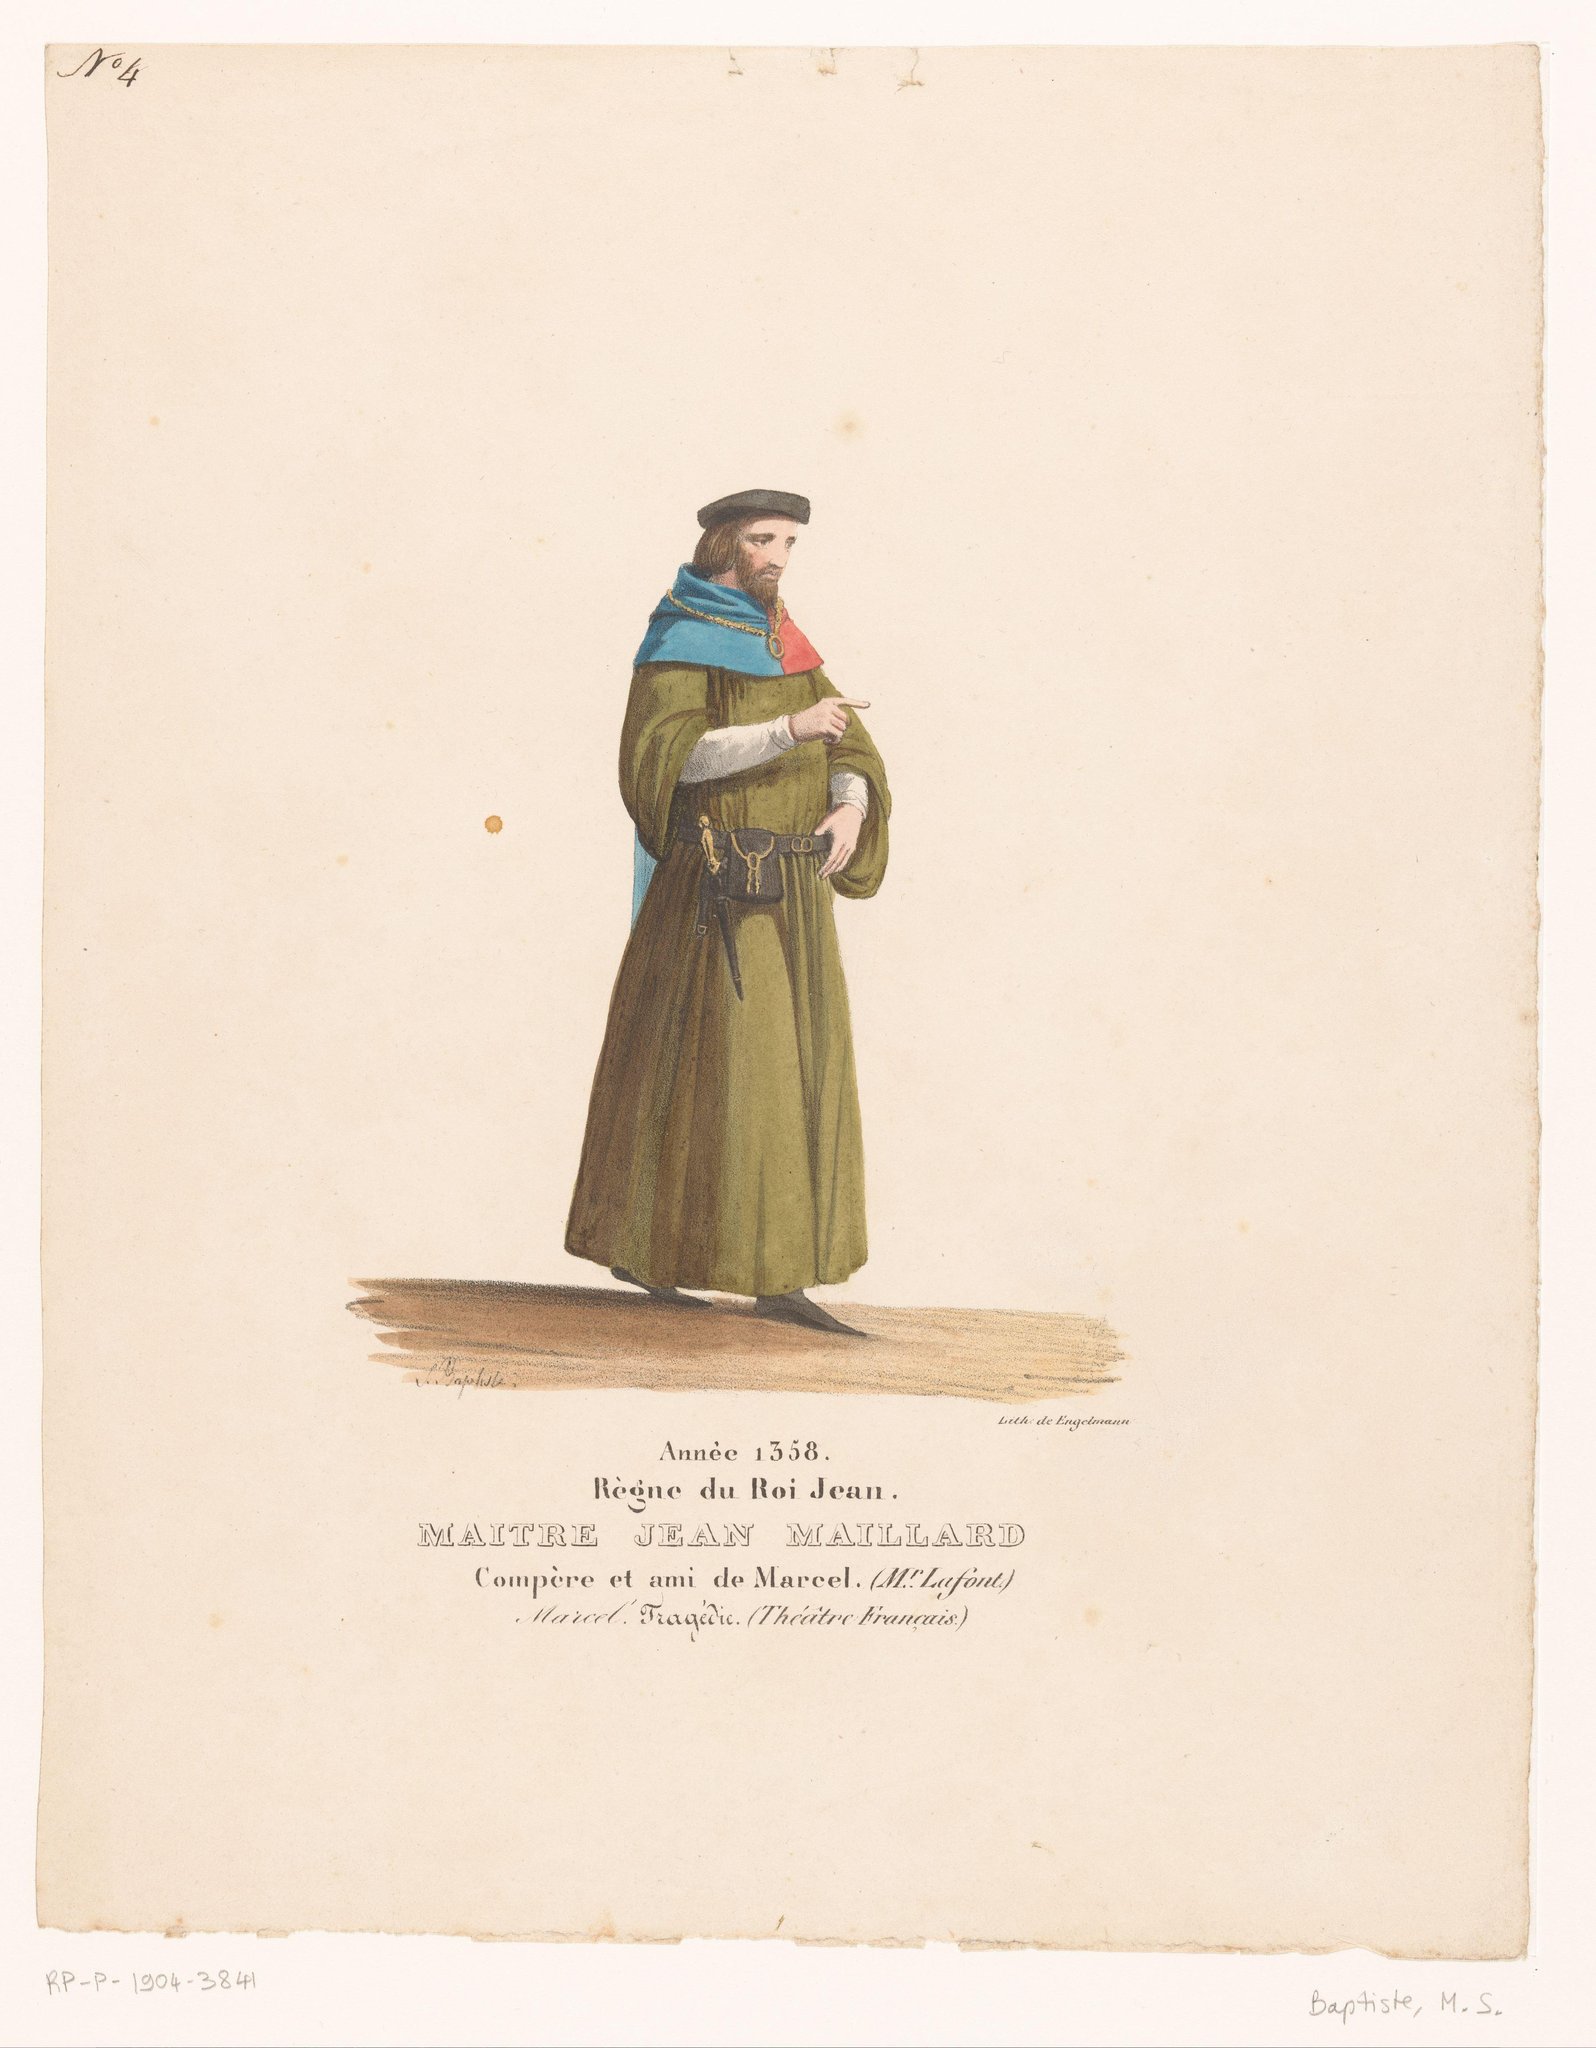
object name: print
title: Théâtre Français: recueil de costumes par MM. J. Alaux et L. Duponchel d'après les dessins manuscrits de la Bibliothèque de la Comédie-Française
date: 1827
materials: paper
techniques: hand coloring, lithograph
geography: paris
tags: stage costume, actor (on the stage), tragedy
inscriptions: collector's mark: Lugt 2228a